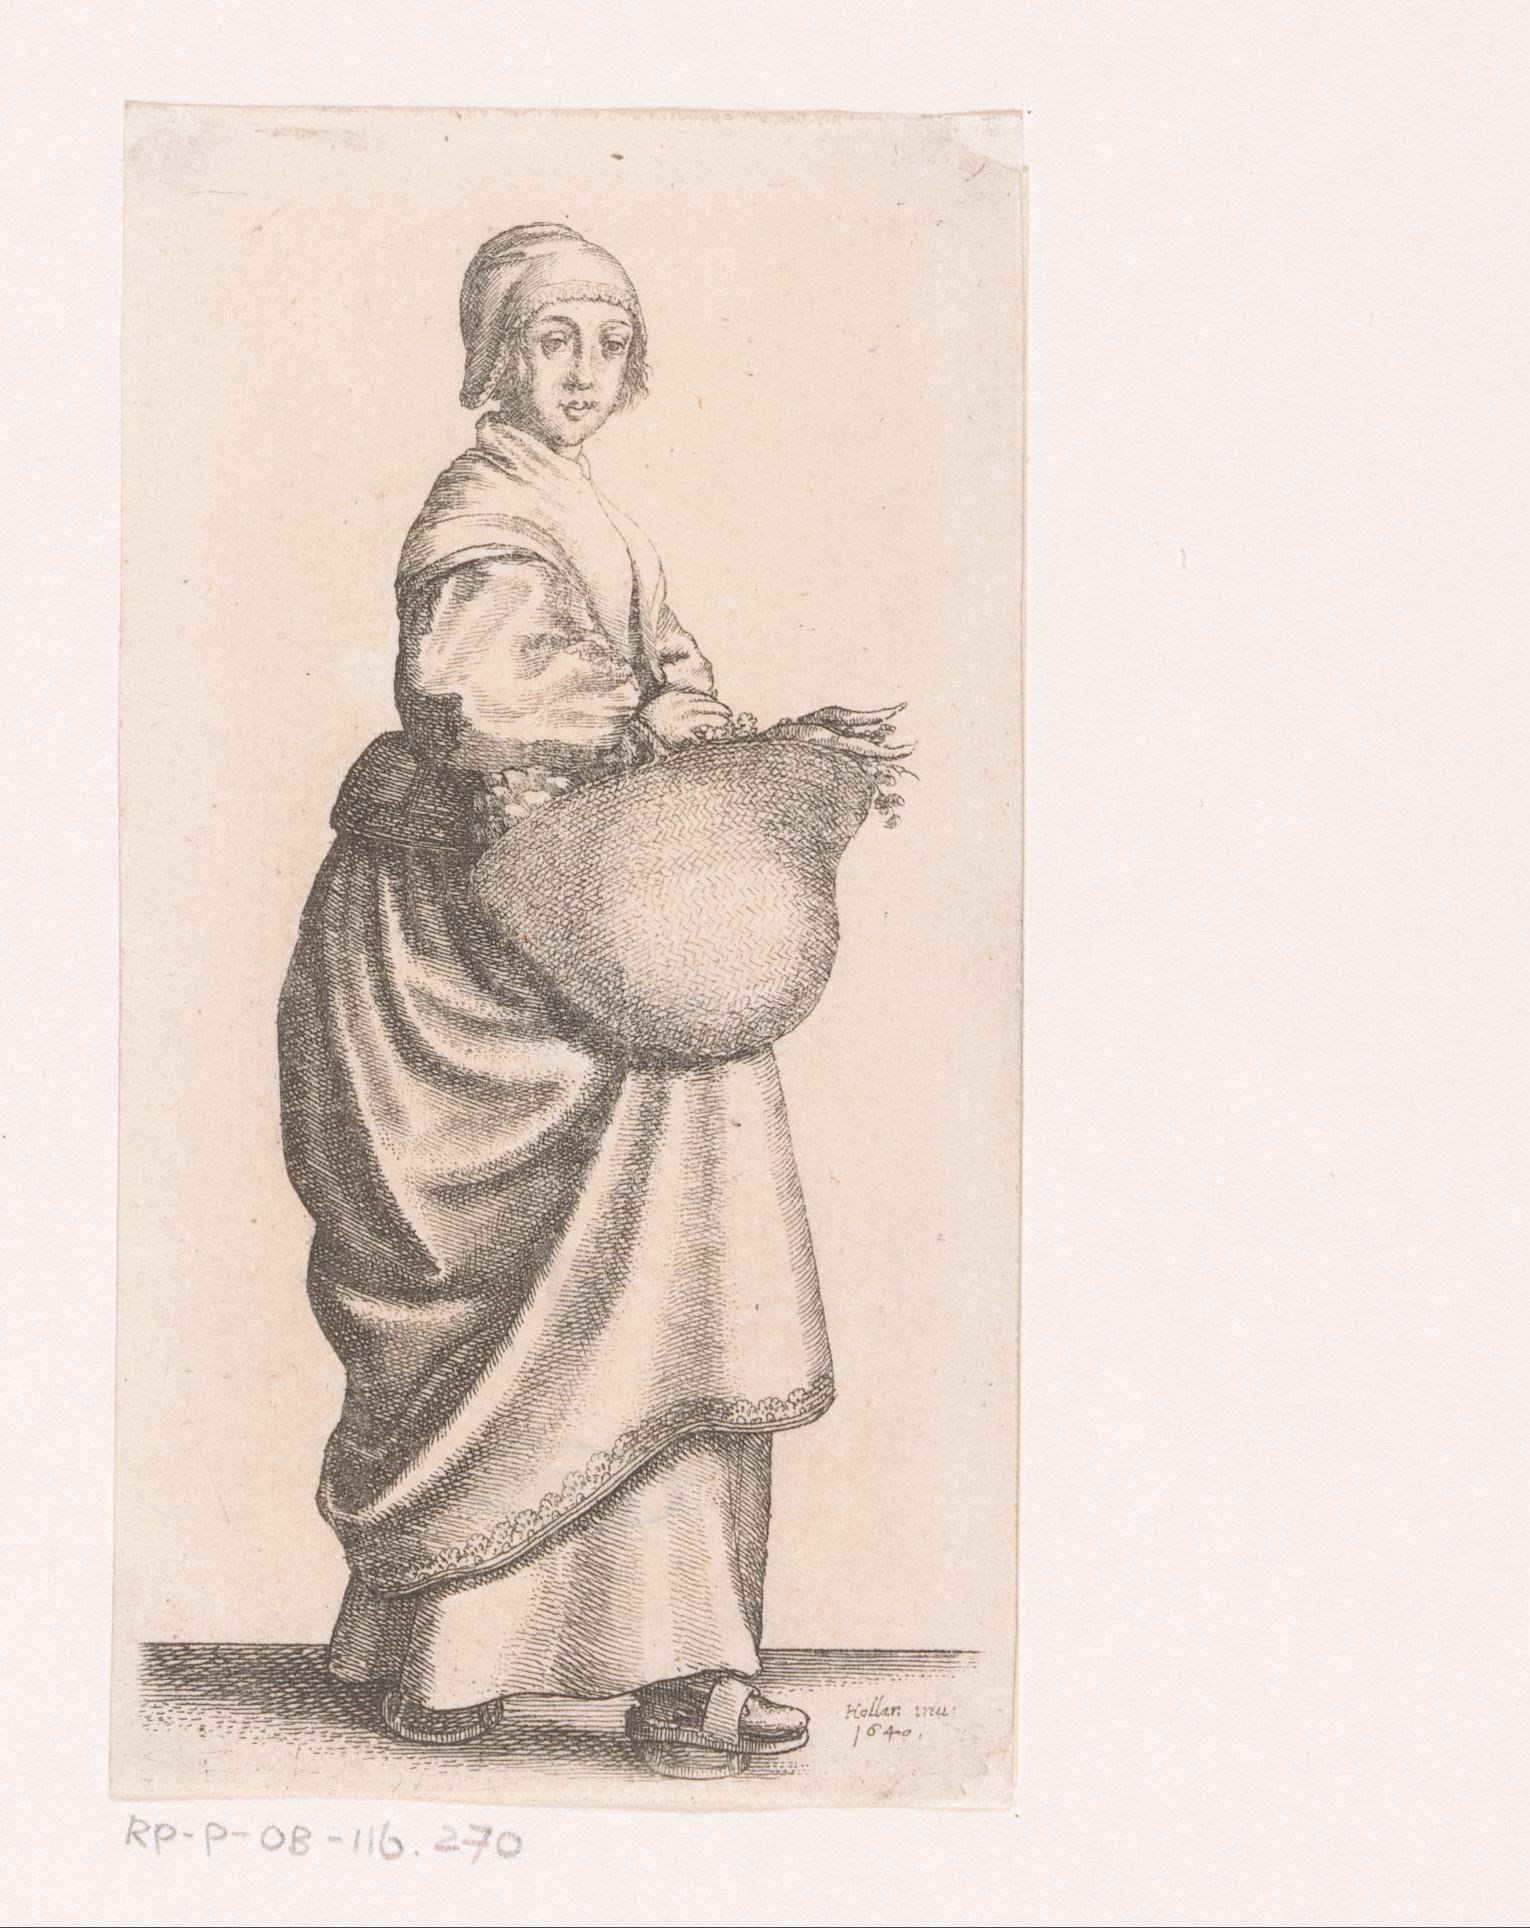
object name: costume print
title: Ornatus Muliebris Anglicanus / The Severall Habits of English Women, from the Nobilitie to the contry woman, they are in these times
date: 1640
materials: paper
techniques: etching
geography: london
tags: europeans: englishmen (+ women), head-gear: cap (+ women's clothes), fashion, clothing (+ lace used for clothes), fashion plates, shoes, sandals (+ women's clothes), dress, gown (+ women's clothes), apron (+ women's clothes), kitchen-maid, kitchen servant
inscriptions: collector's mark: Lugt 2228, collector's mark: Lugt 2760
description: Engelse keukenmeid, naar rechts gekeerd, met een grote mand aan de arm. Ze draagt een kapje afgezet met kant op het hoofd en een onversierde halsdoek om de schouders. Trippen aan de voeten.